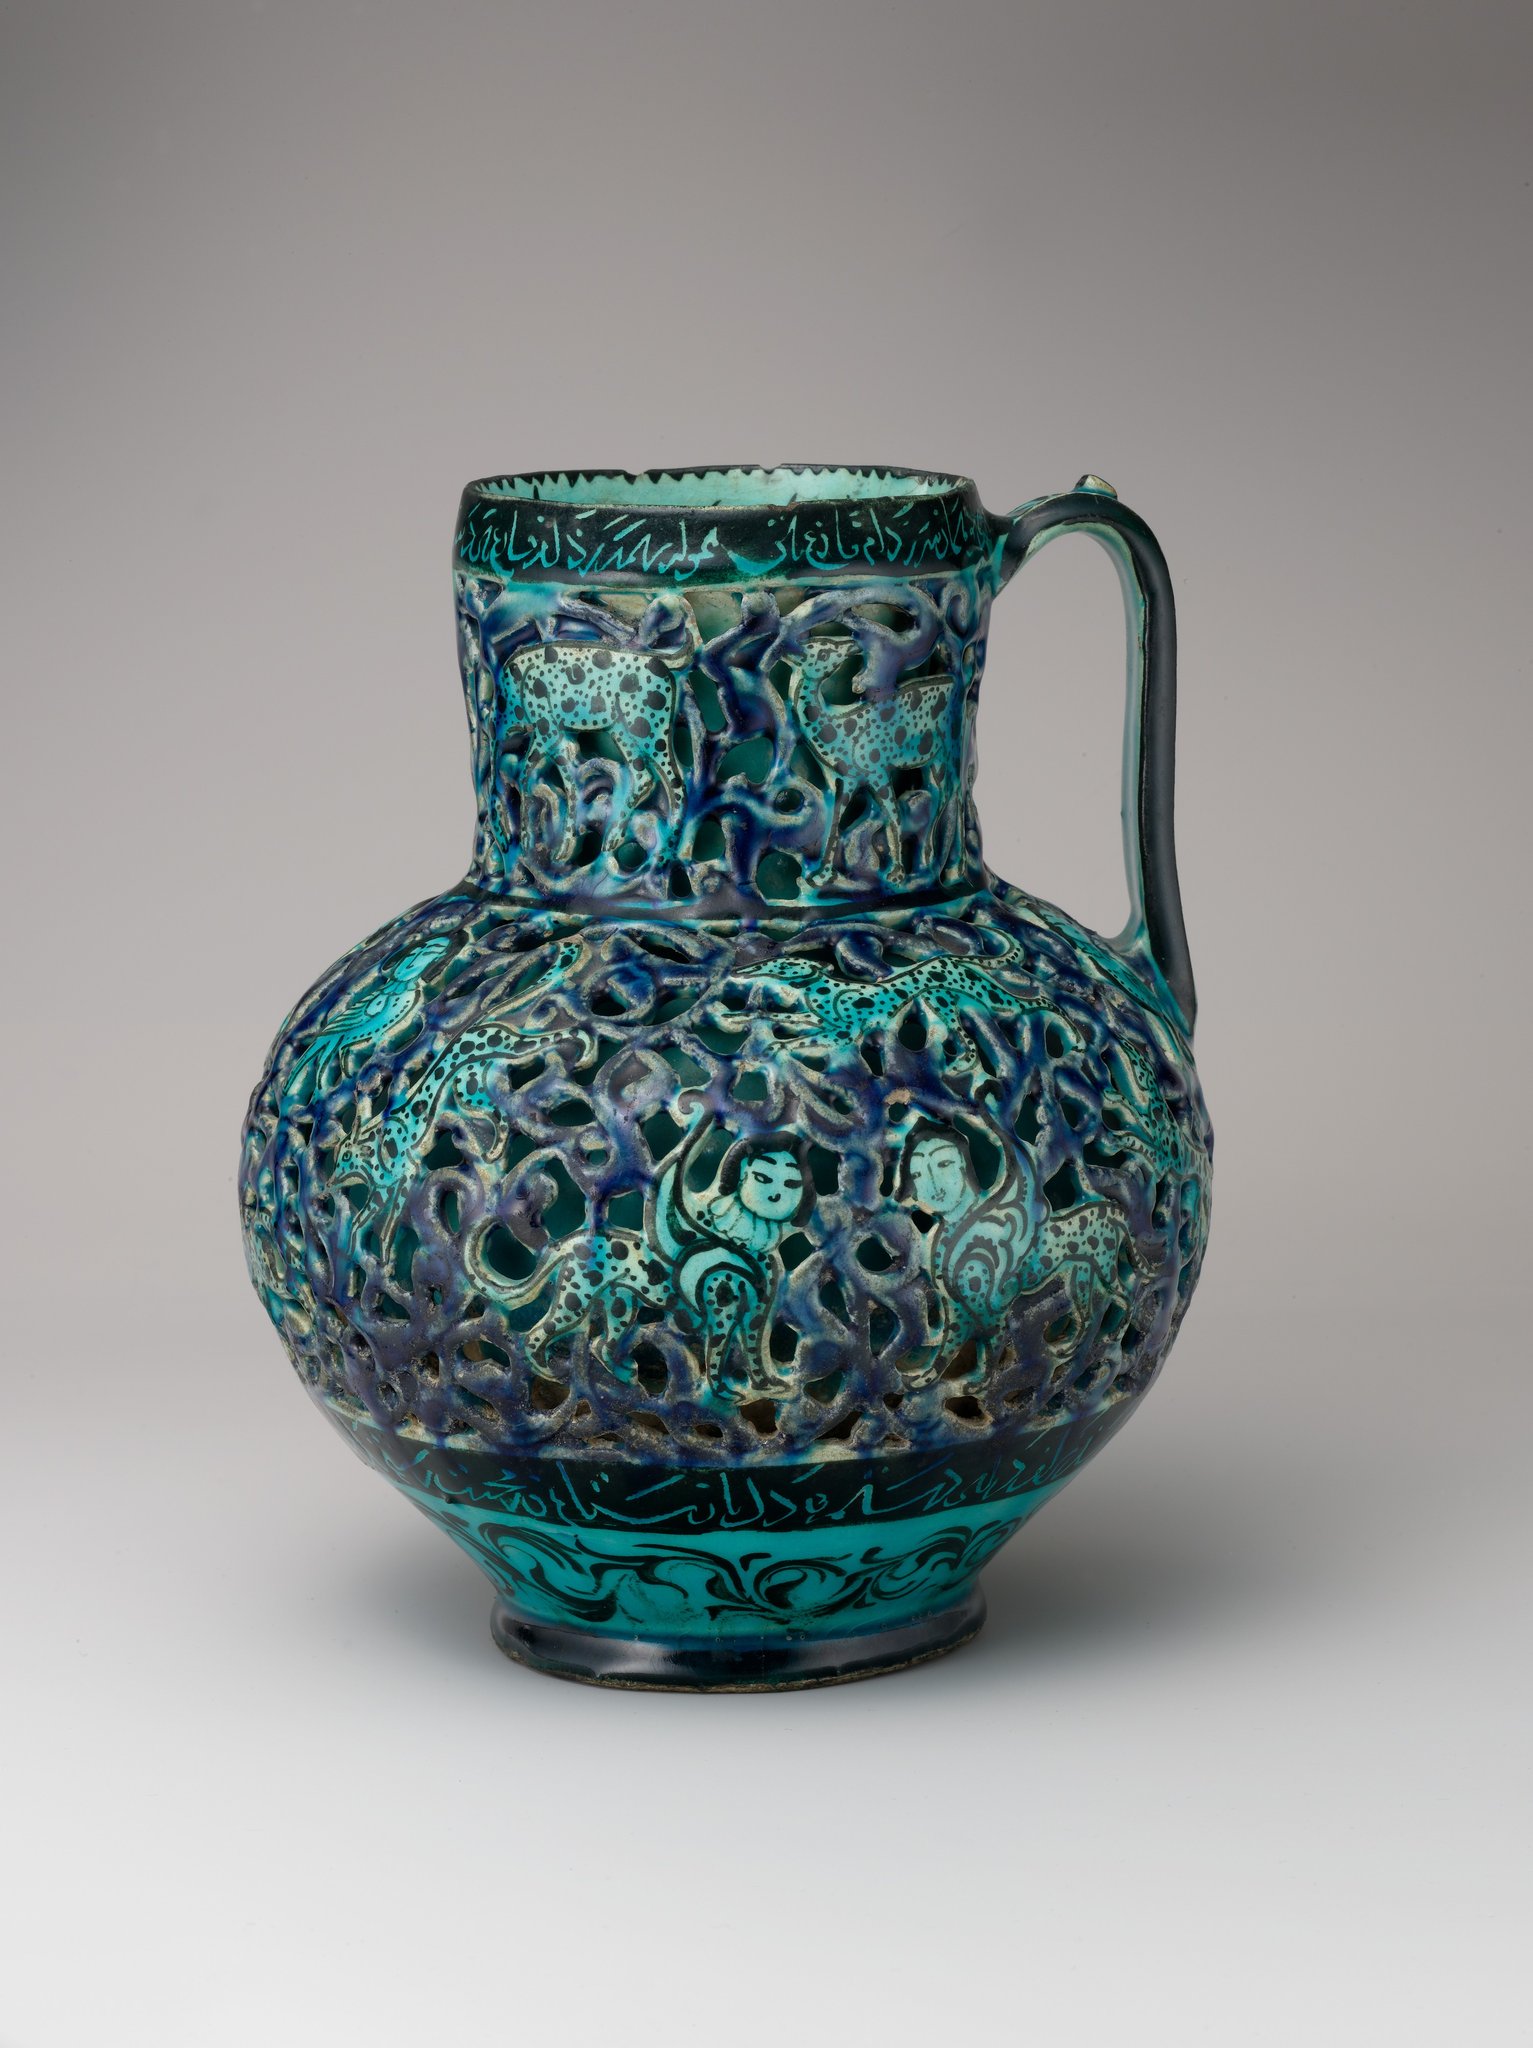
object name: ewer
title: Pierced Jug with Harpies and Sphinxes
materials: stonepaste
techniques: glazing, painting, underglaze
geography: iran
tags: mythical creatures,sphinx,cheetahs,deer,dogs